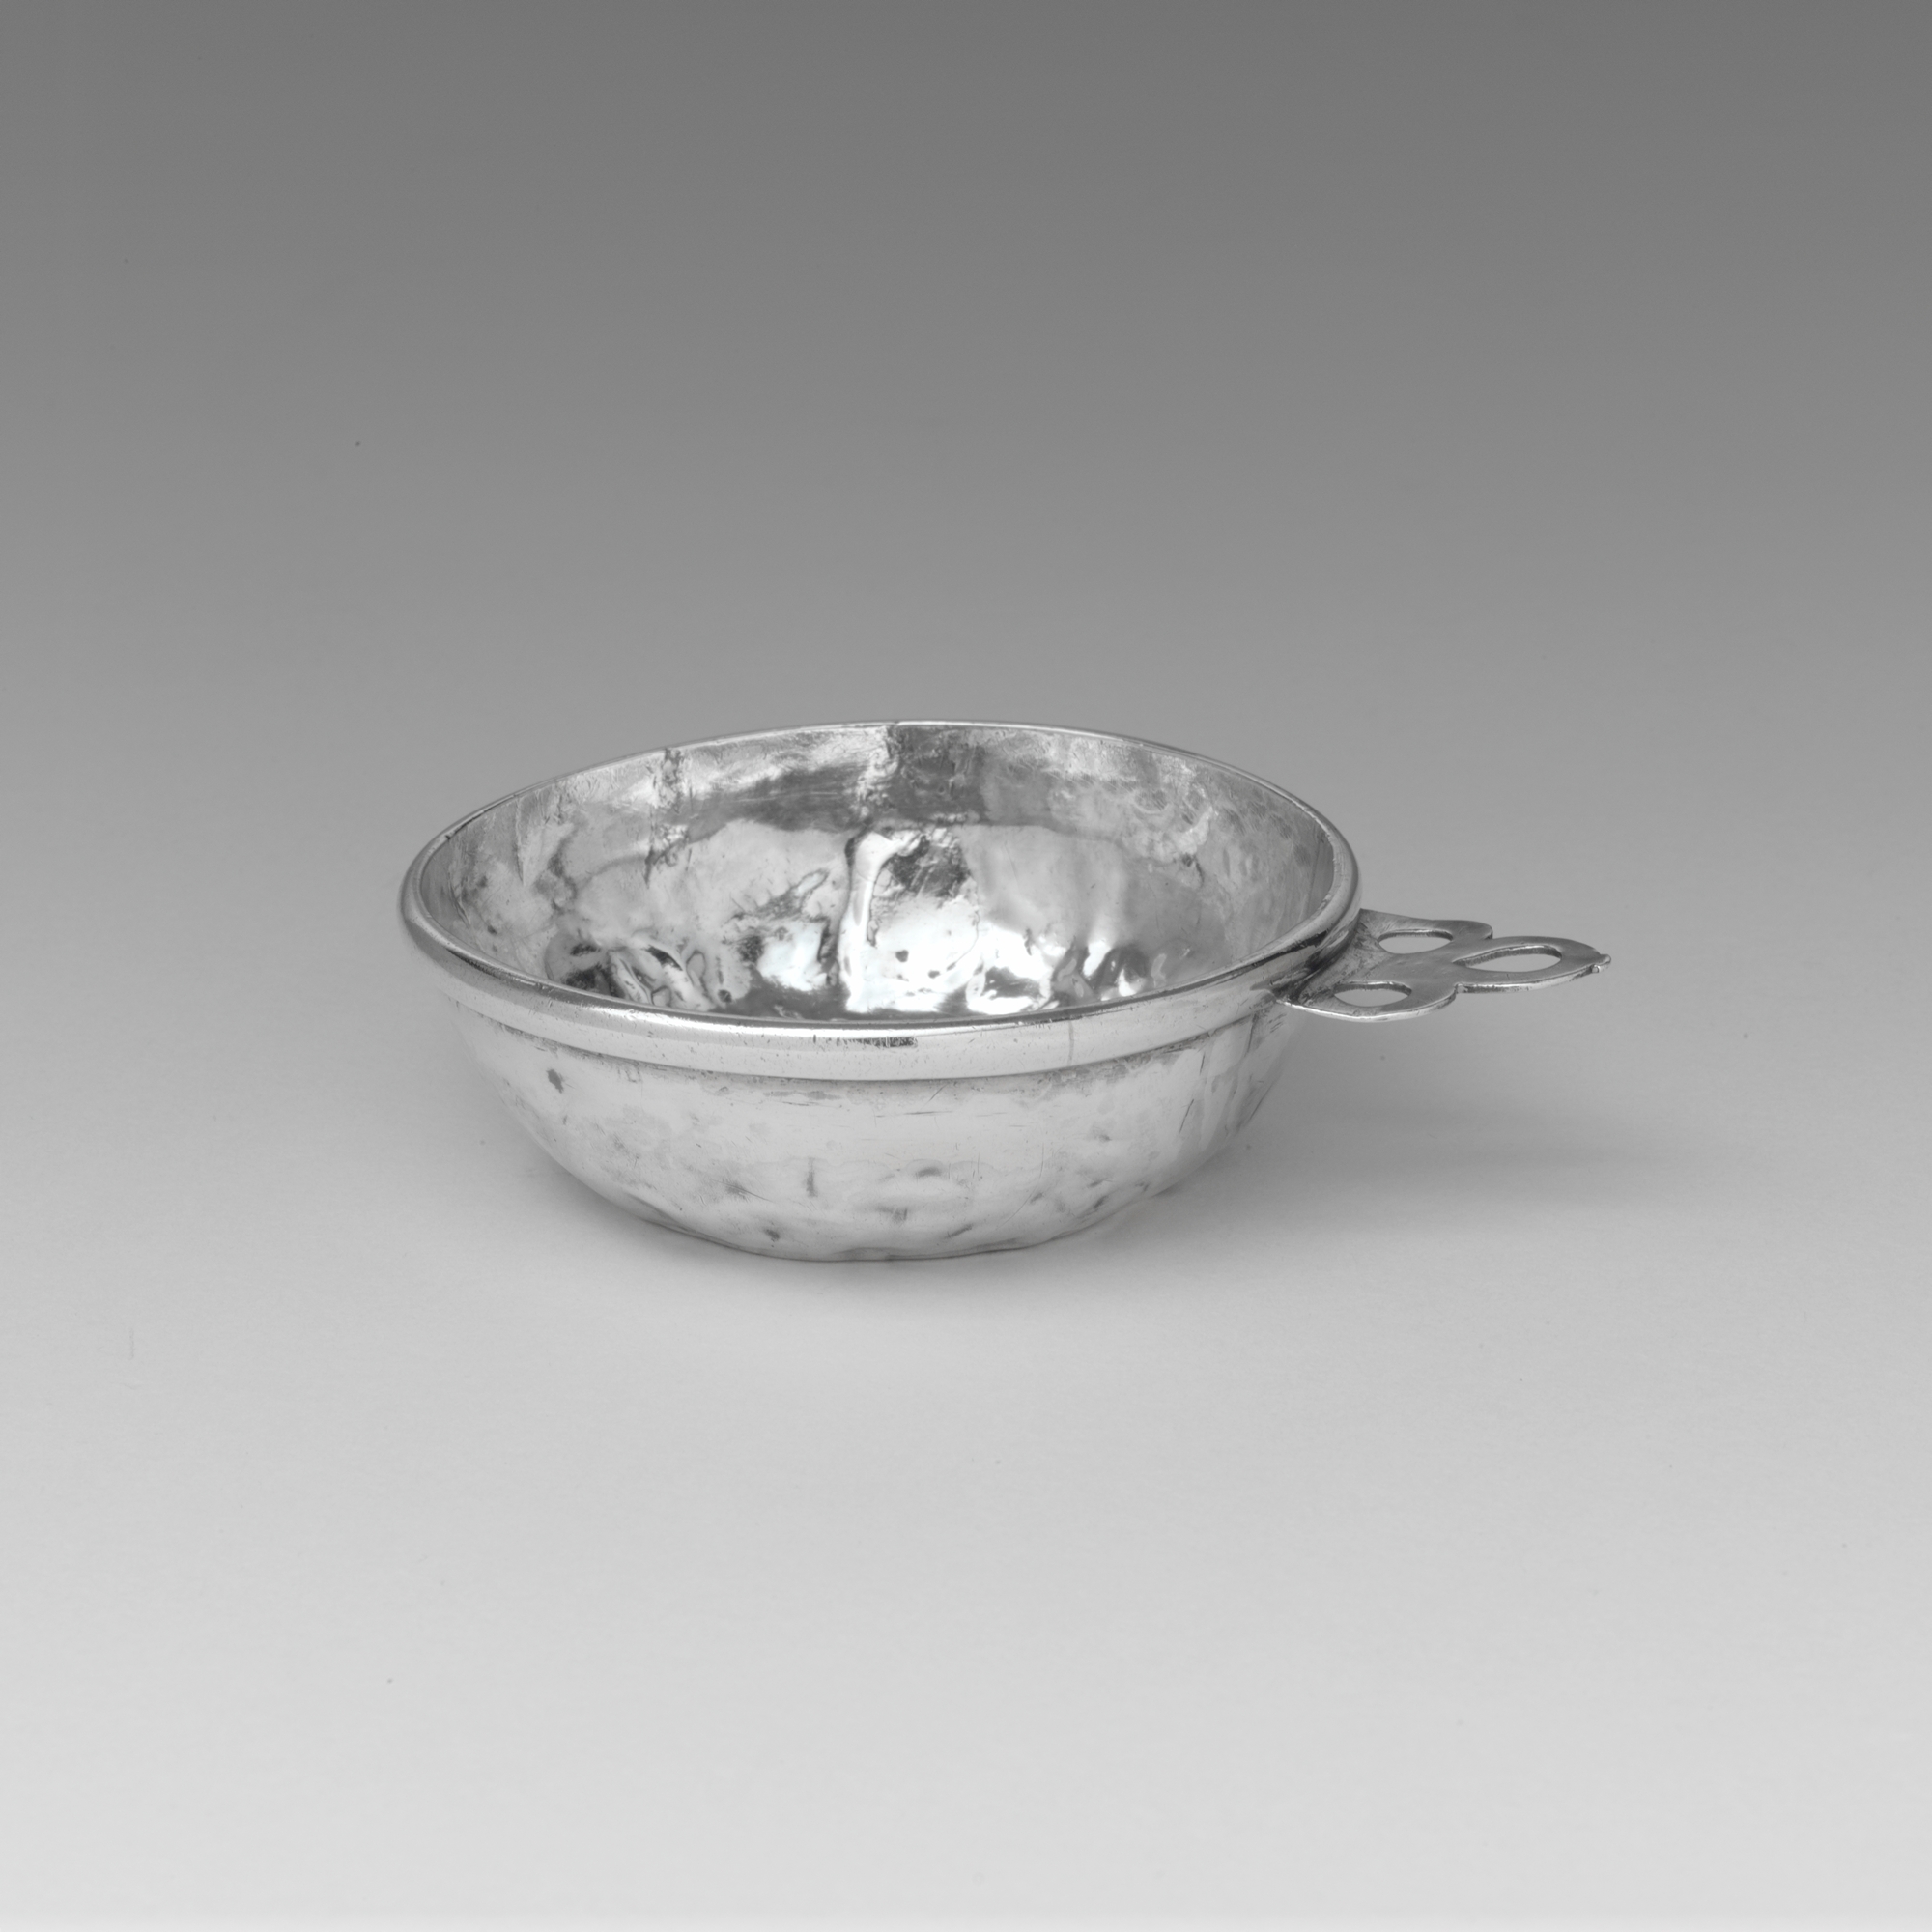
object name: cup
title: Dram Cup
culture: american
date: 1700-1730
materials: silver